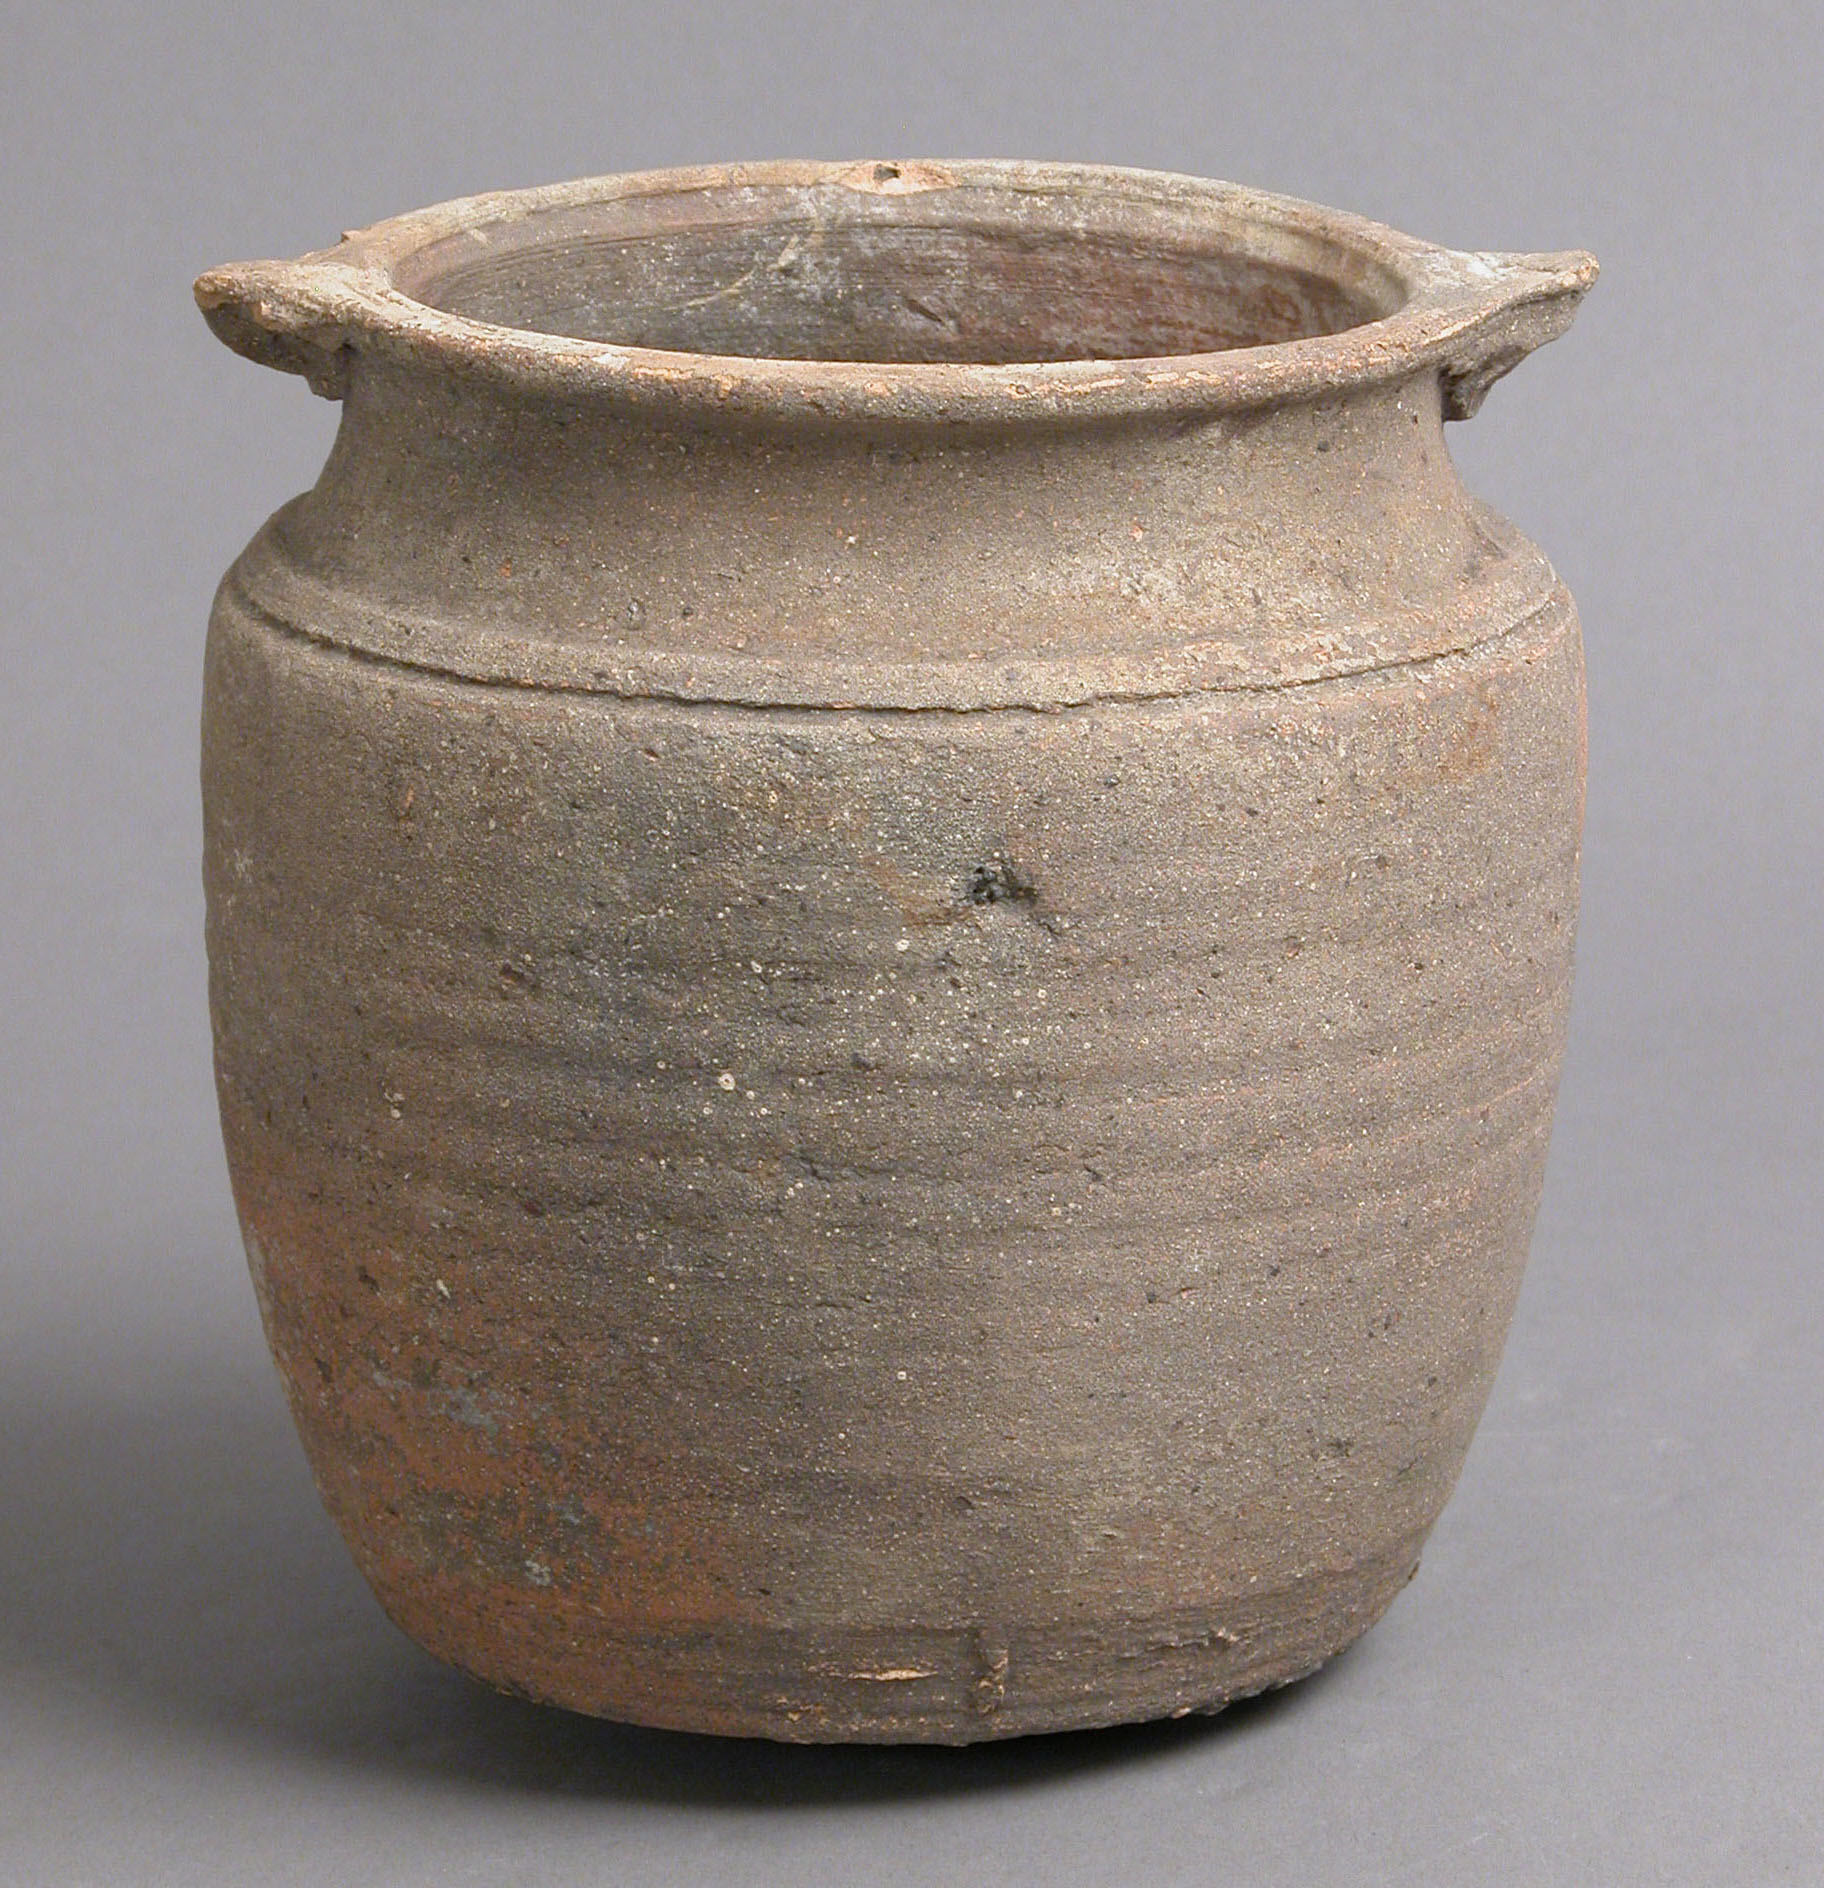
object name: pot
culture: coptic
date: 301-700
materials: earthenware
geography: egypt